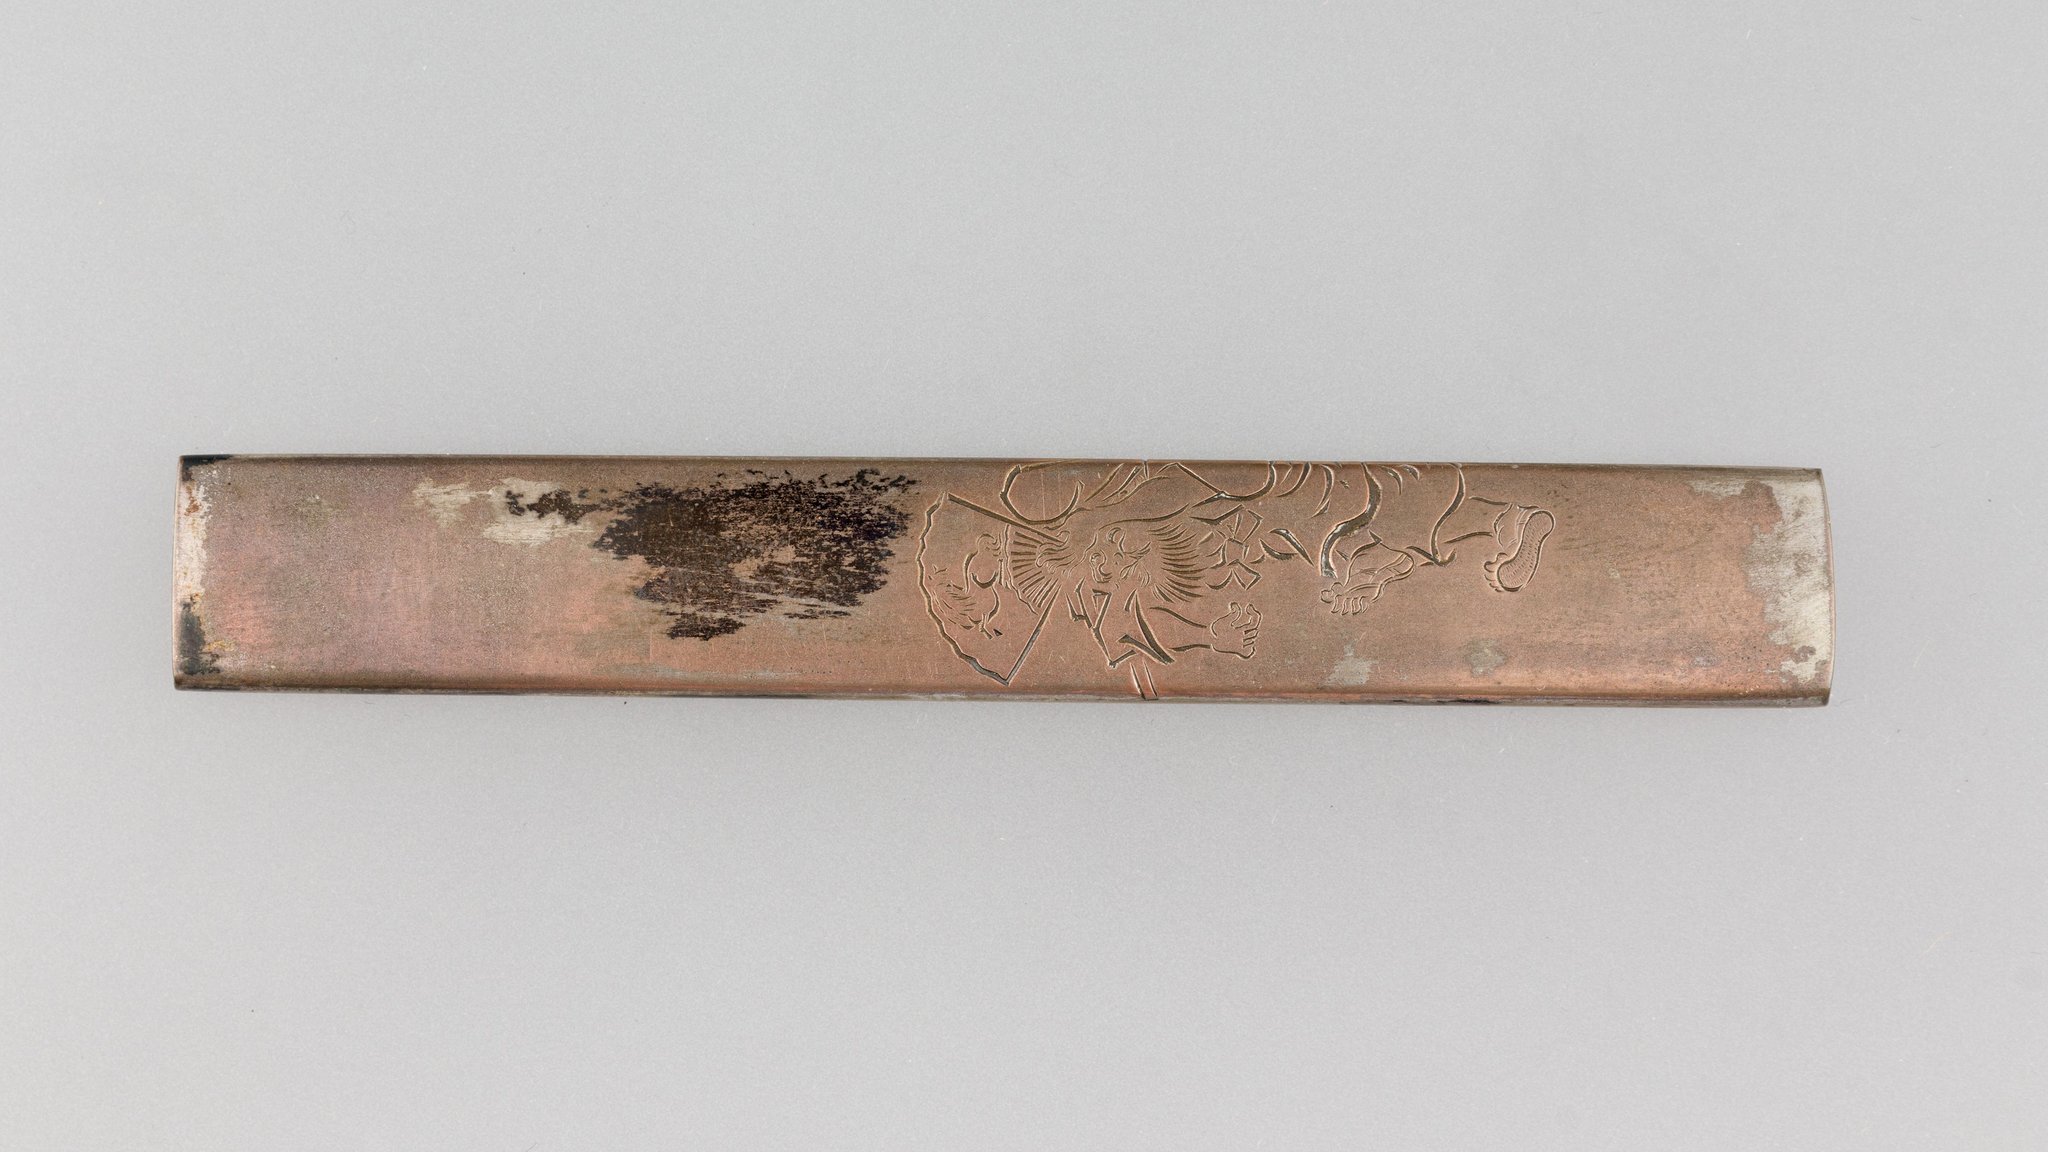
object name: knife handle kozuka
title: Knife Handle (Kozuka)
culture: japanese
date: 1669-1733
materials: silver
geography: japan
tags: fans,men